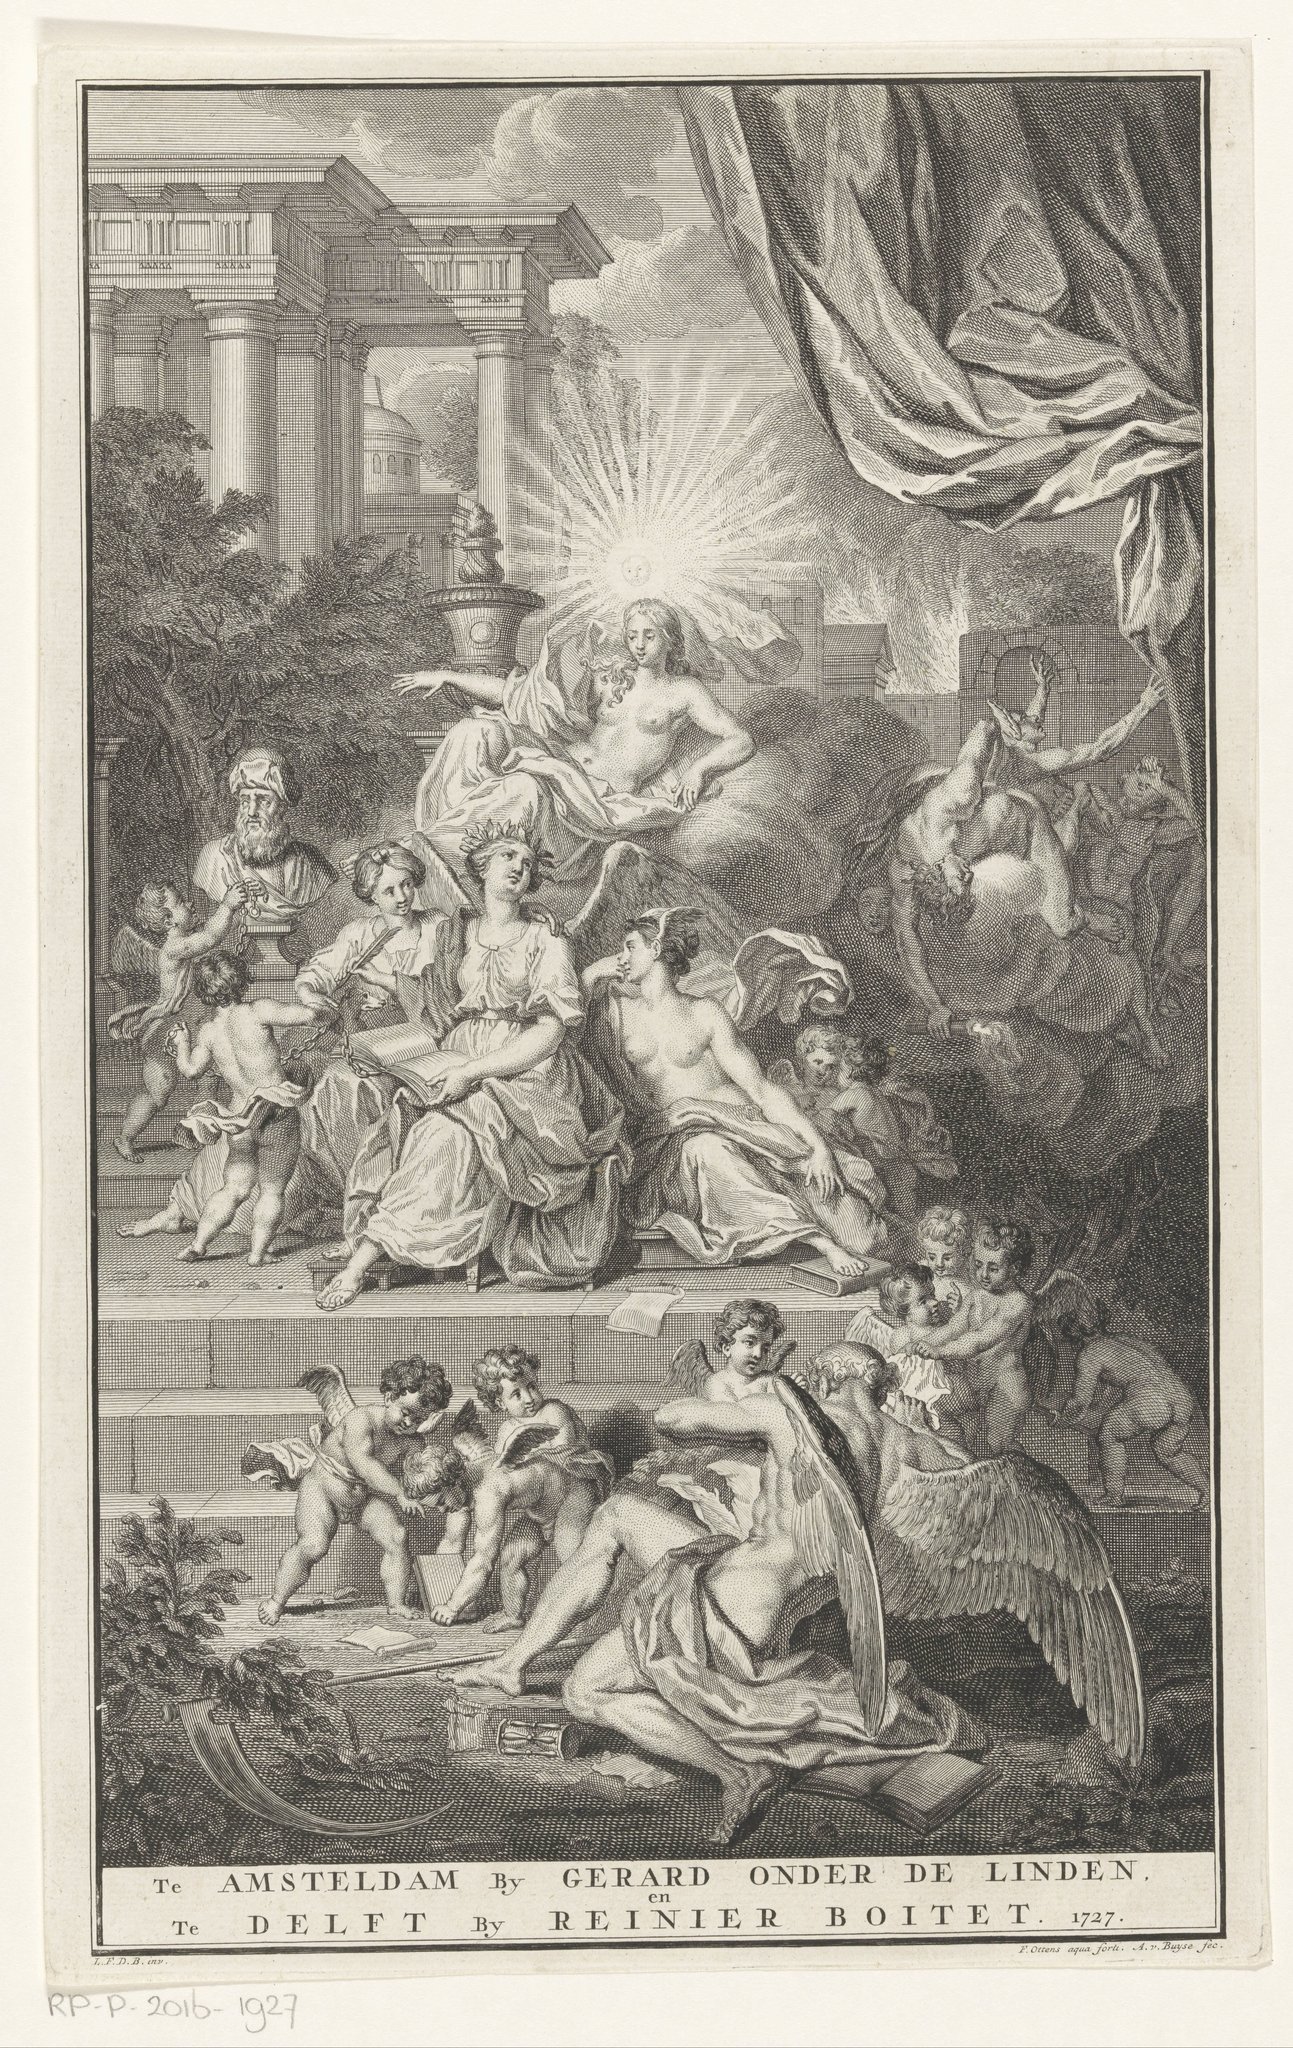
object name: print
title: Geschiedenis overwint Tijd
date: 1727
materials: paper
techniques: engraving, etching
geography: amsterdam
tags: truth; 'verità' (ripa), 'historia'; 'historia' (ripa), father time, man with wings and scythe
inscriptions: collector's mark: Lugt 2228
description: Een allegorie op de schrijfkunst. Geschiedenis zit op een trap en schrijft een boek, zij wordt omringd door putti en allegorische figuren. Op een wolk boven haar zit Waarheid met een zon boven het hoofd. Op de grond ligt de gevallen Vader Tijd, omringd door putti met boeken en papieren.